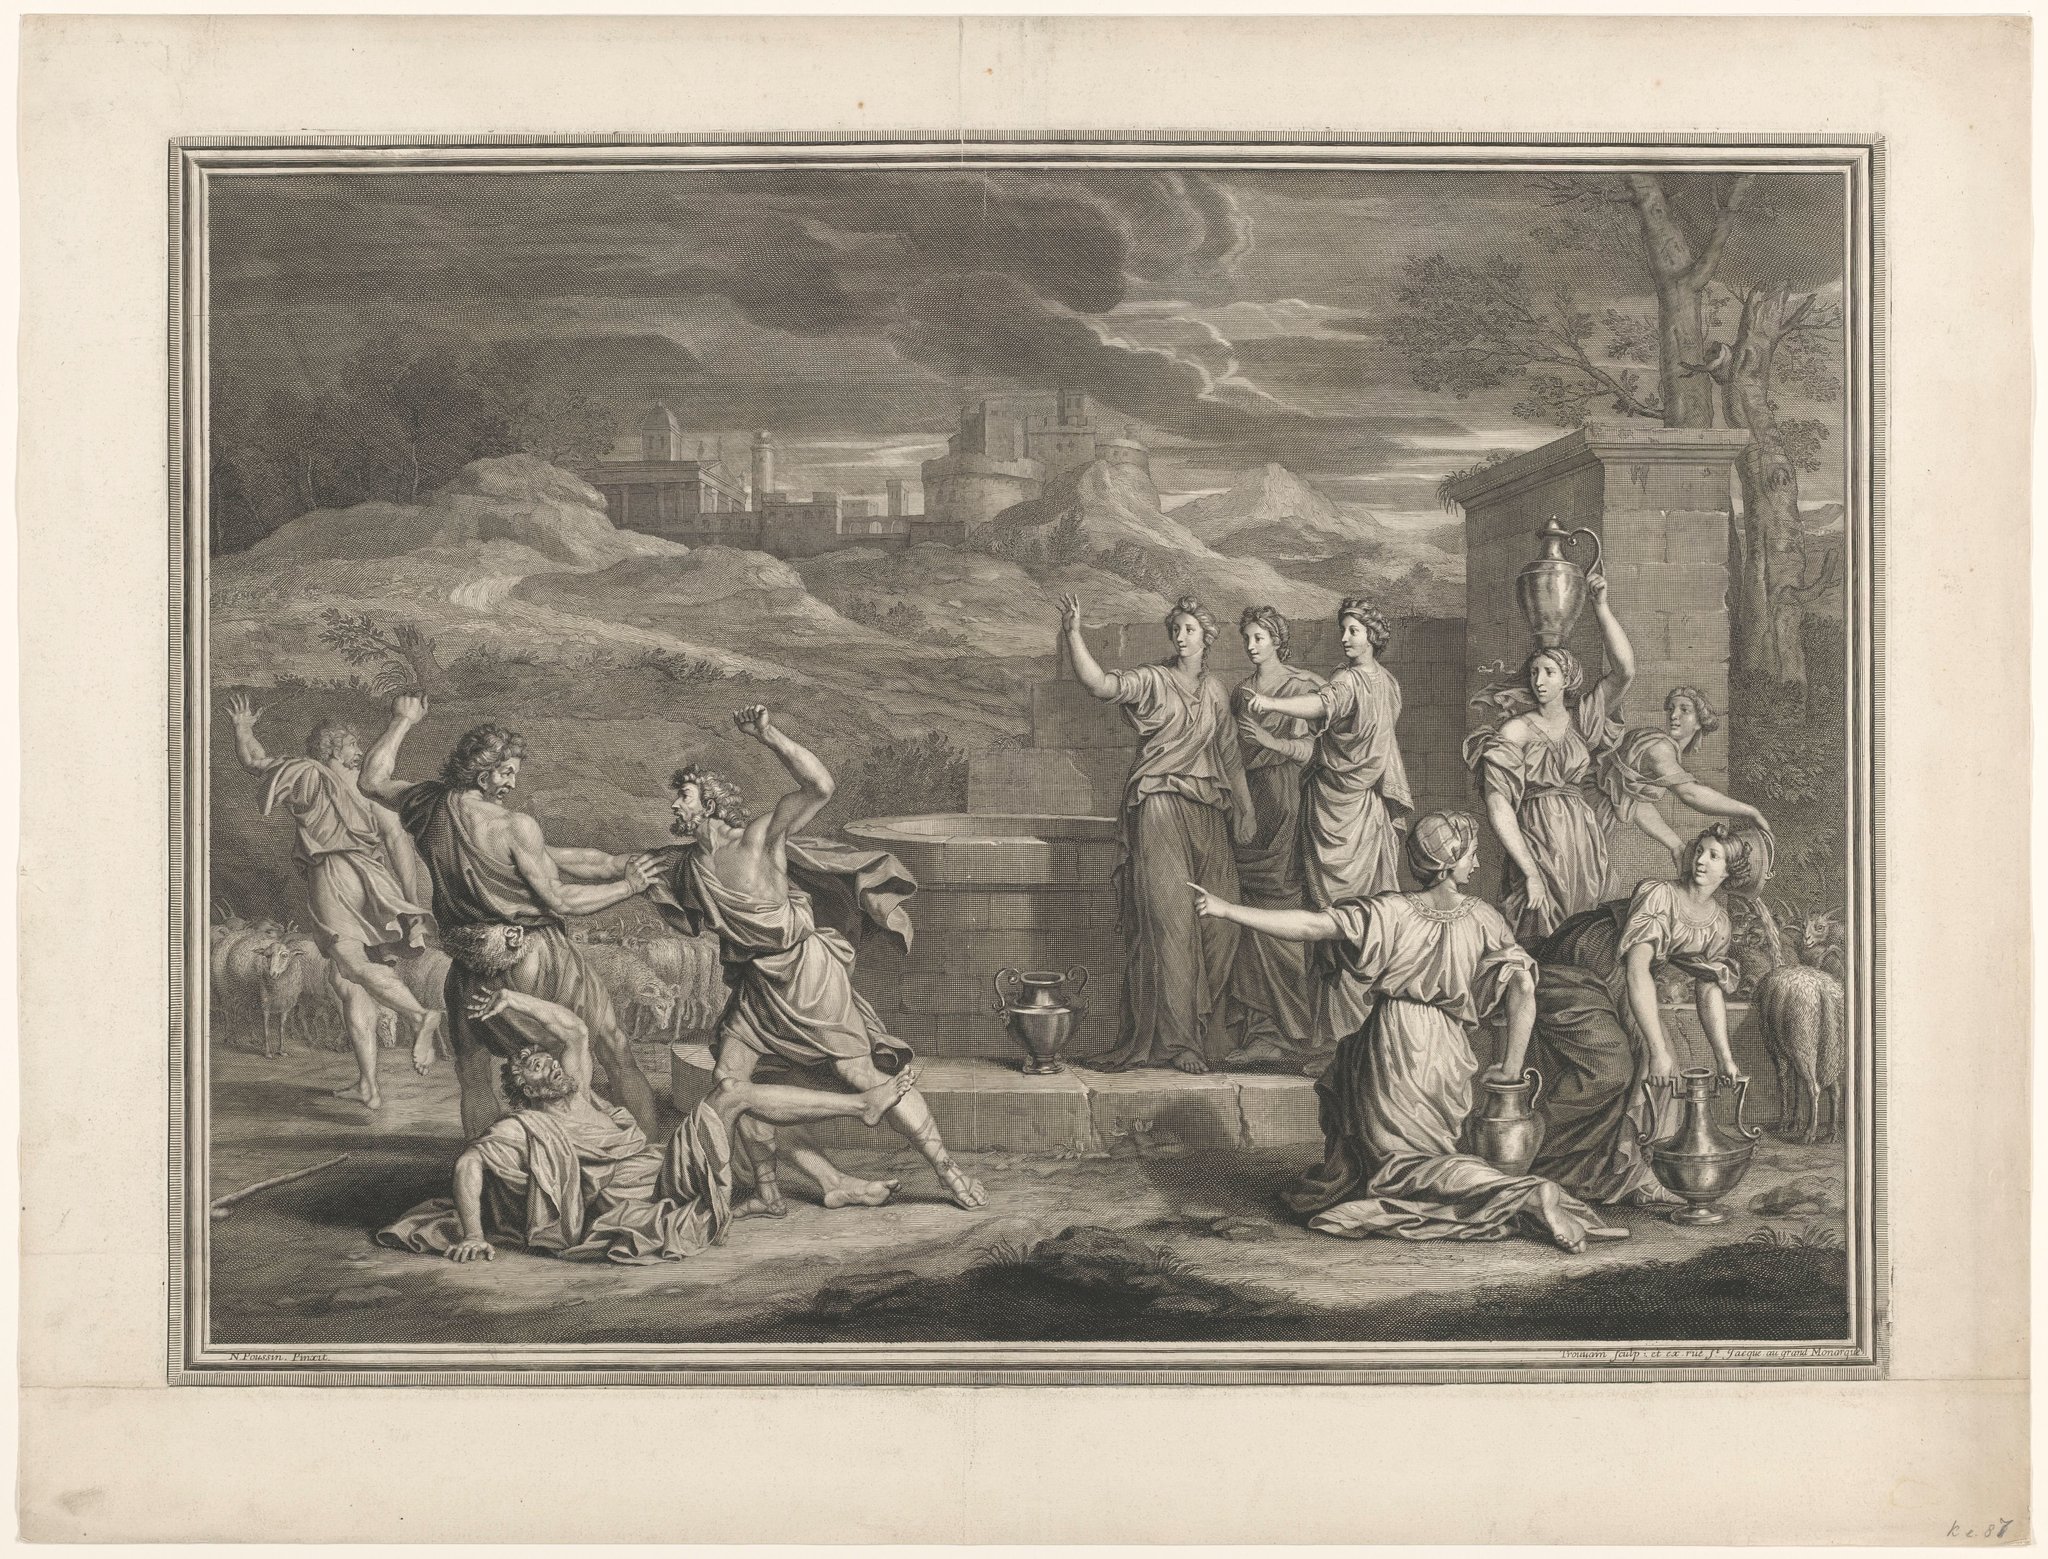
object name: print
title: Mozes verdedigt de dochters van Jetro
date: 1666-1708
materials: paper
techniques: engraving, etching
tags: moses drives away the shepherds who wanted to prevent jethro's daughters from watering their father's flock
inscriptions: collector's mark: Lugt 240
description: Mozes valt de herders aan die de dochters van Jetro beletten hun schapen water uit de put te geven.